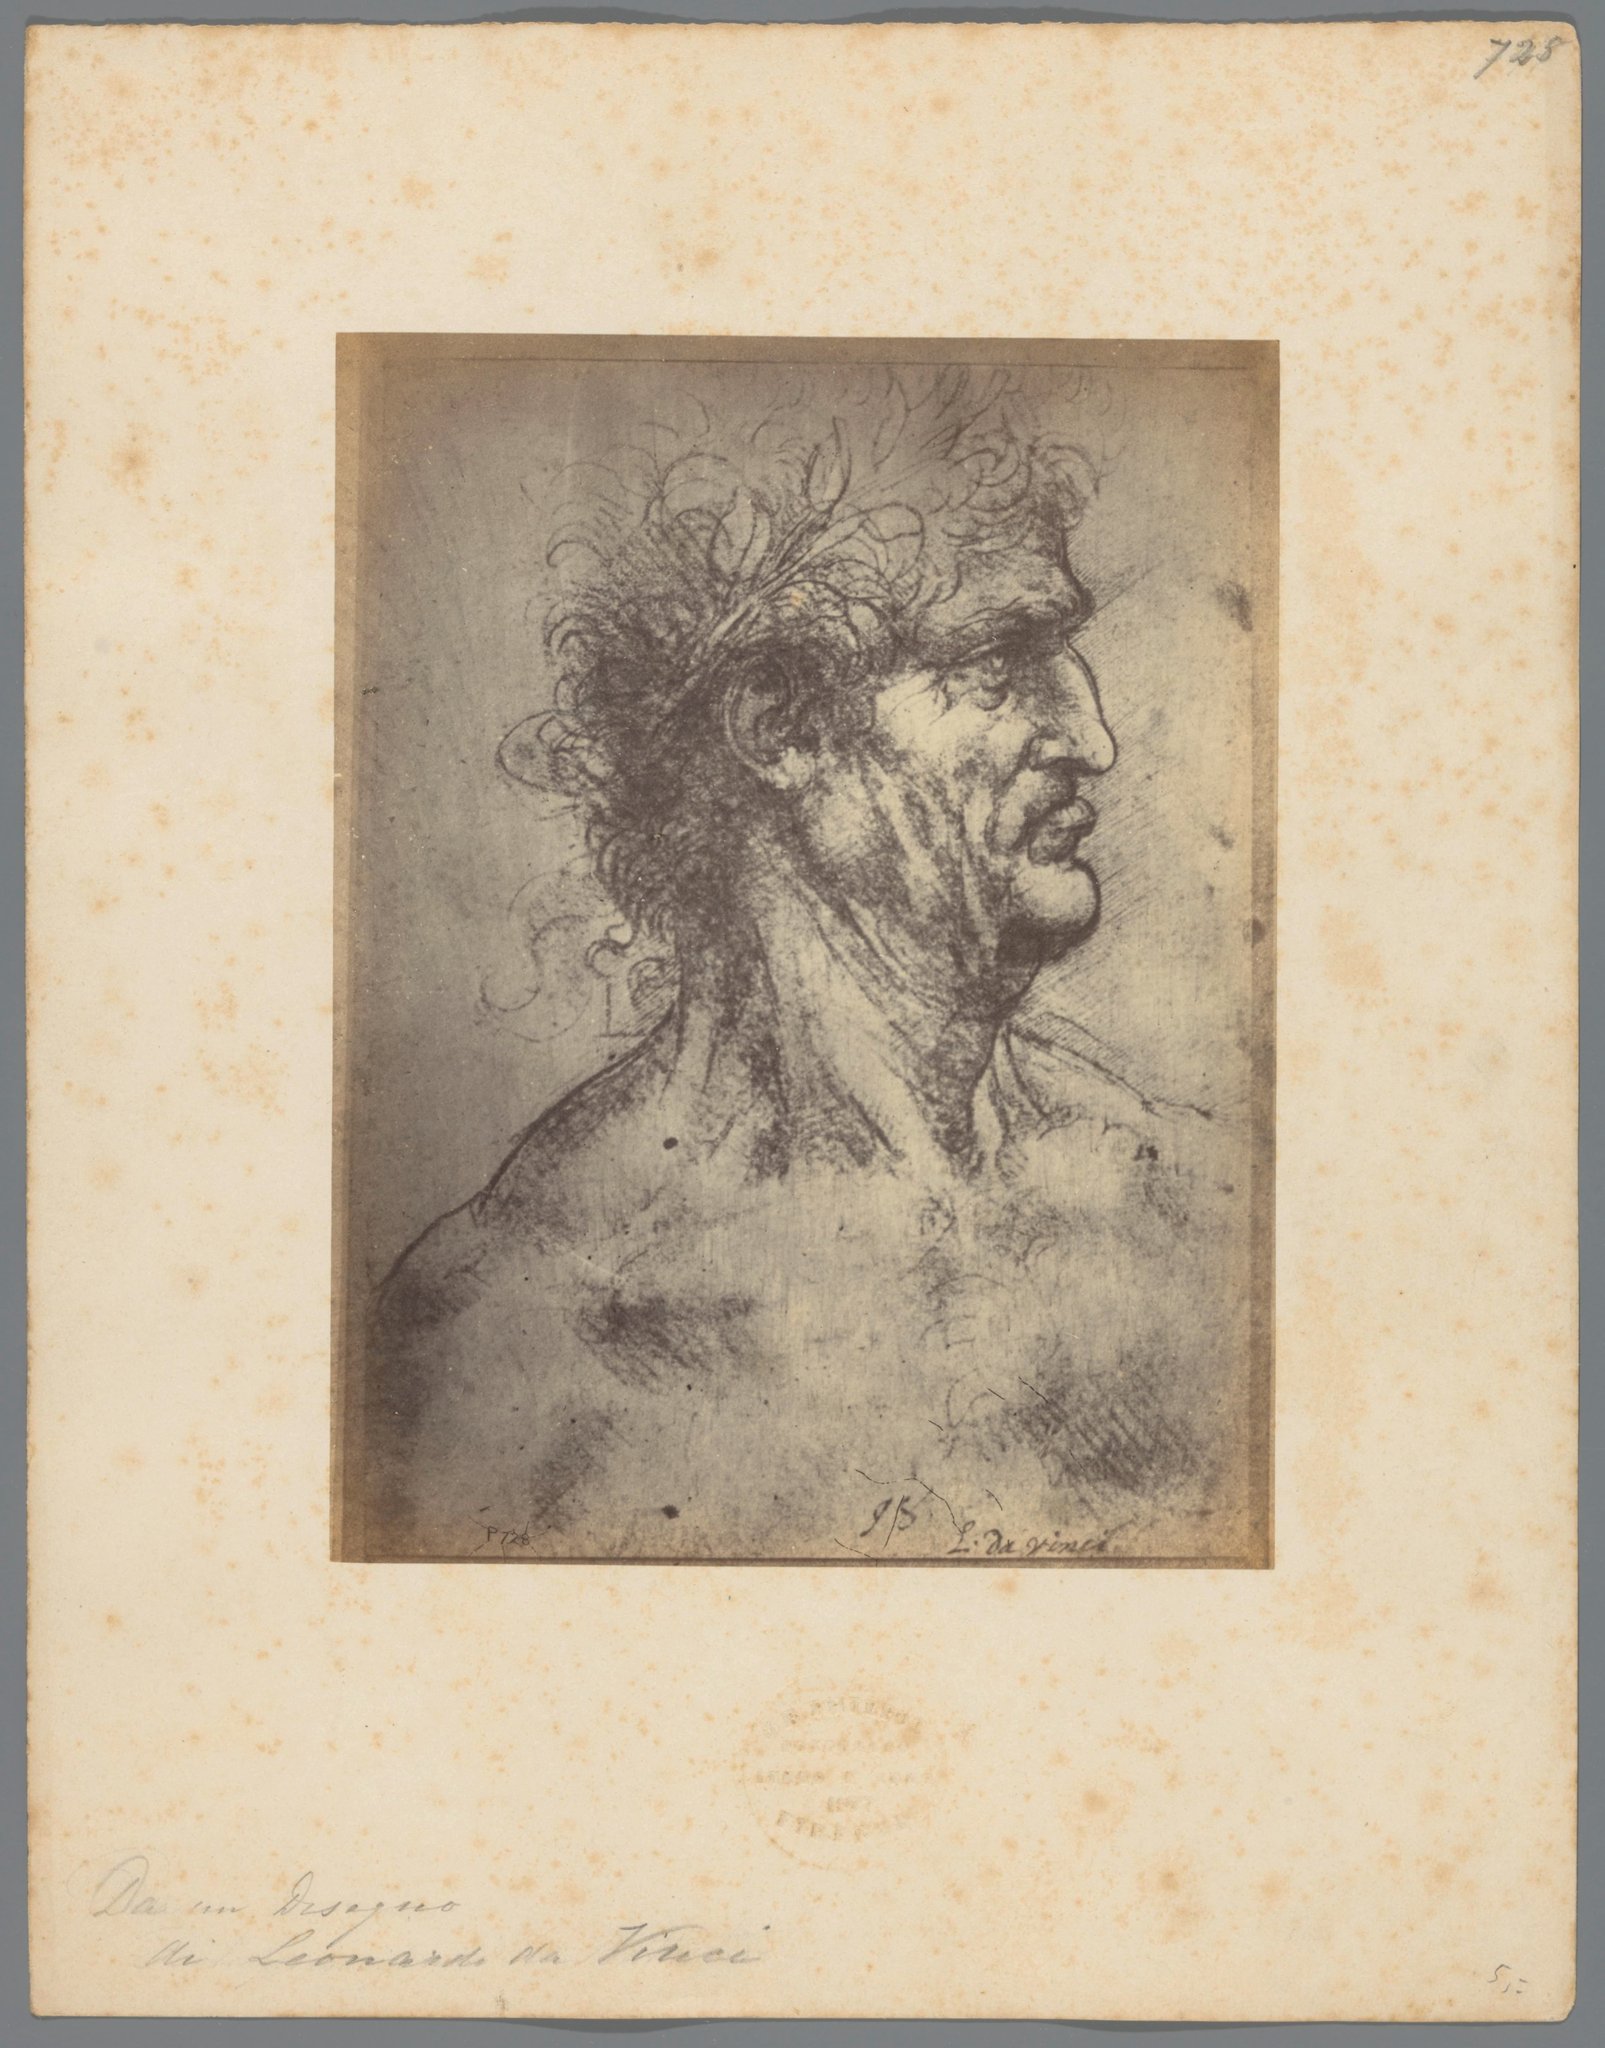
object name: photograph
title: Fotoreproductie van een tekening van een mannenkop van Leonardo da Vinci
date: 1851-1878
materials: cardboard, paper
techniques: albumen print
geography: florence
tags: drawing, sketch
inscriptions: check stamp: ‘J.B. Philpot / Fotografo / Lungo d'Arno / 1187 / Firenze’, inscription: ‘5,=’, number: ‘P728’, inscription: ‘Da in Desagno/ di Leonardo da Vinci’